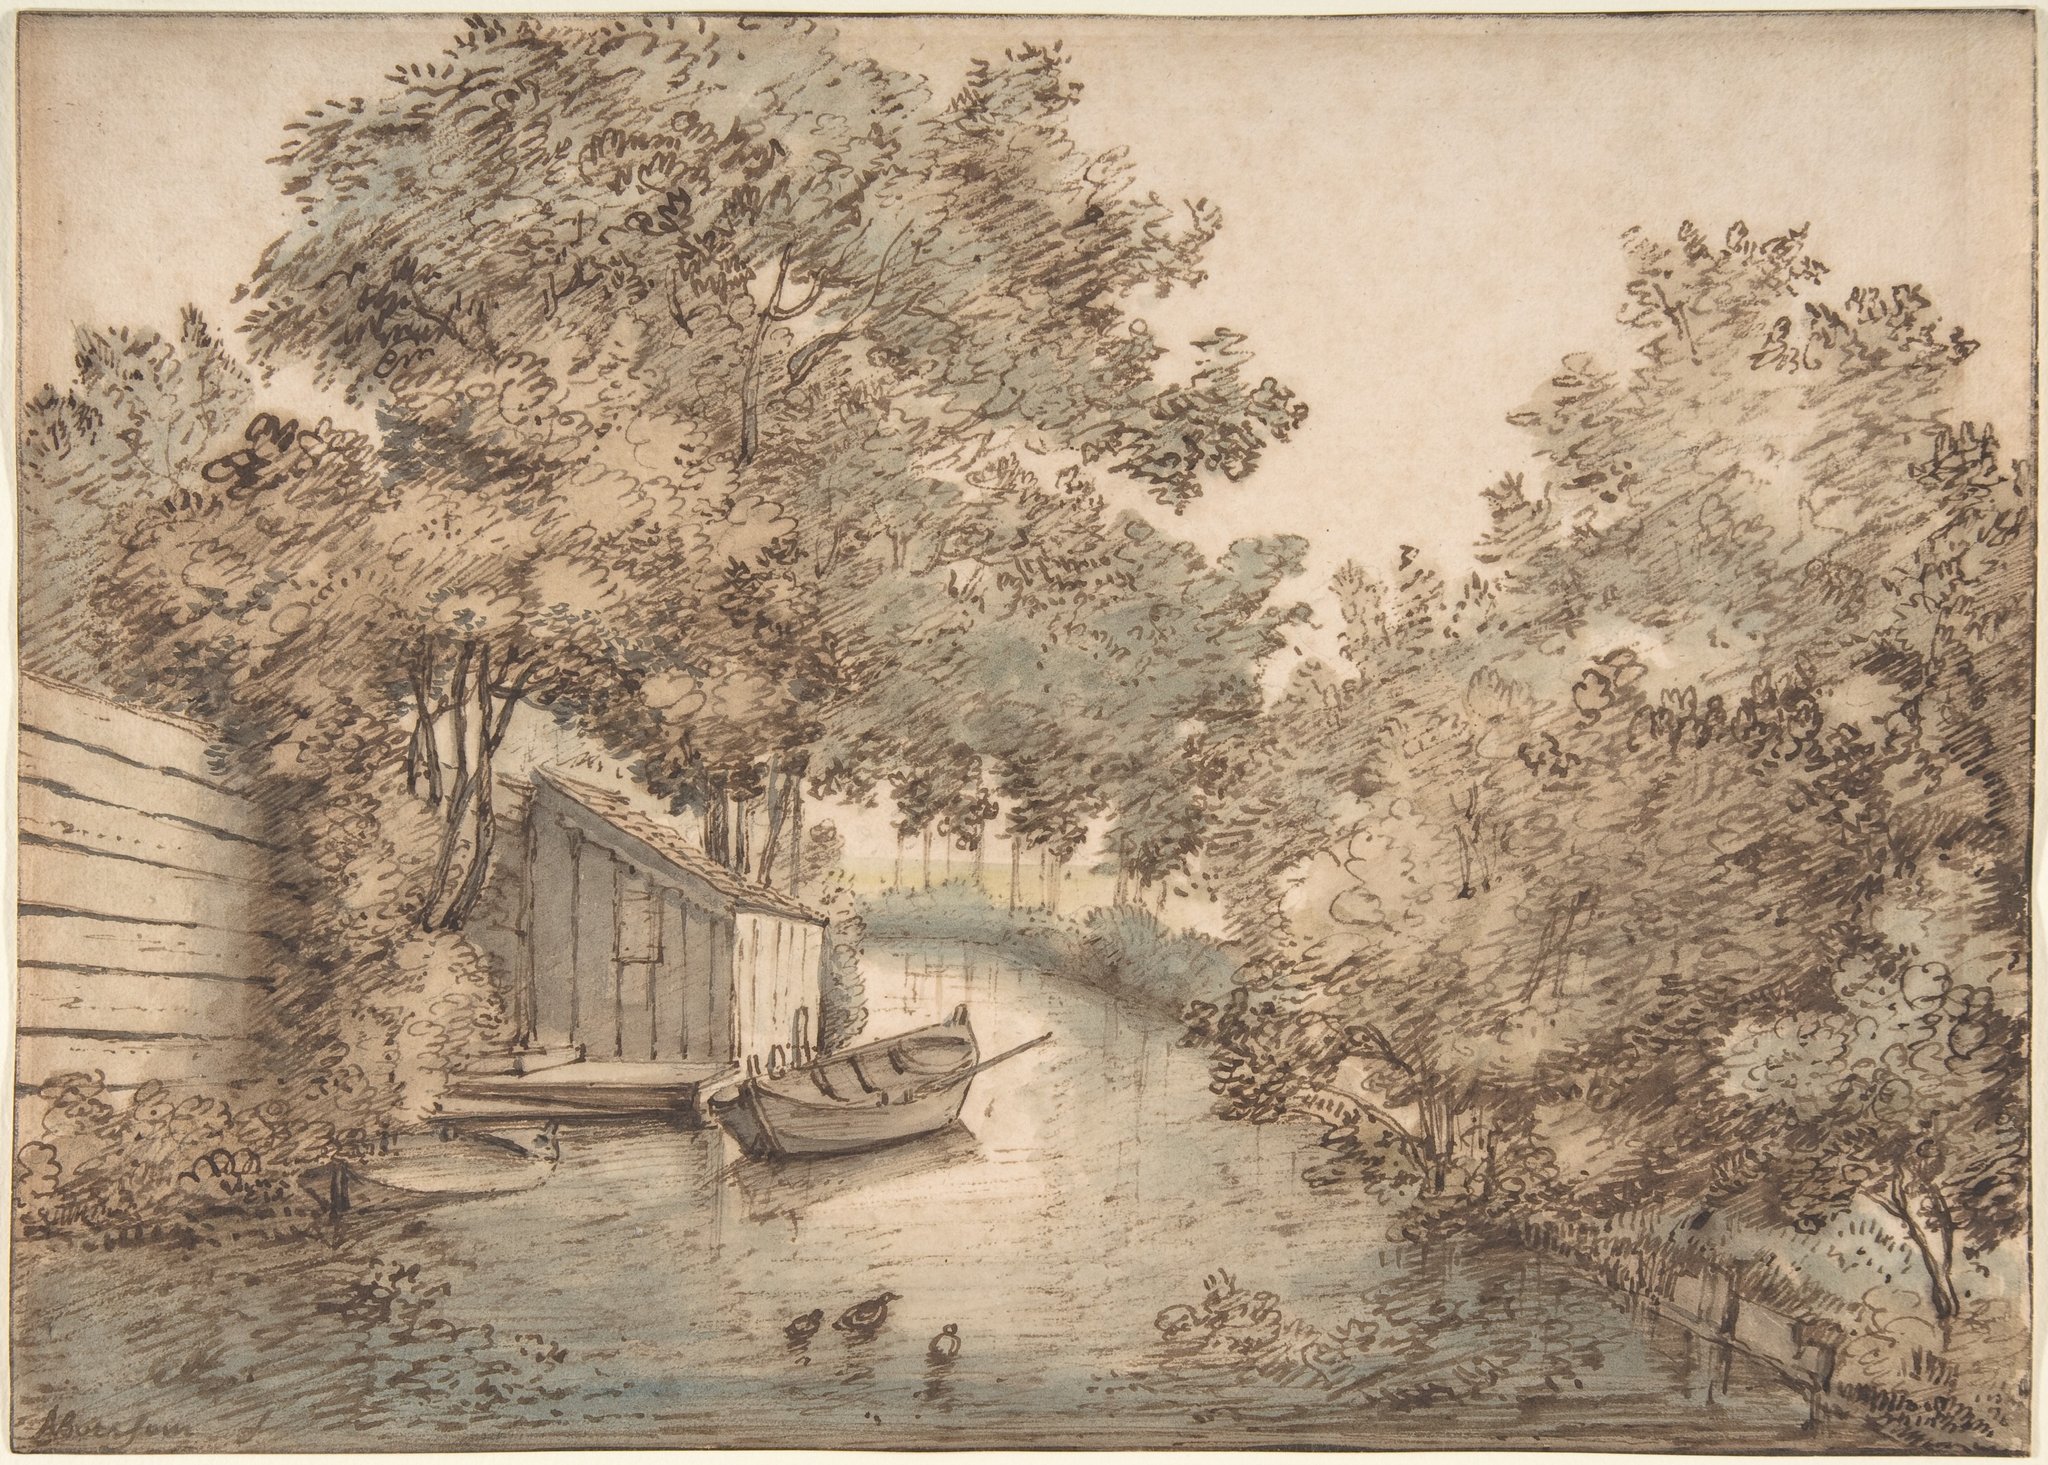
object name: drawing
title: Canal with a Boat and Ducks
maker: anthonie van borssom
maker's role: artist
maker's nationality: dutch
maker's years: 1631-1677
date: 1601-1700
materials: ink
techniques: brush, pen, wash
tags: ducks,canals,trees,boats